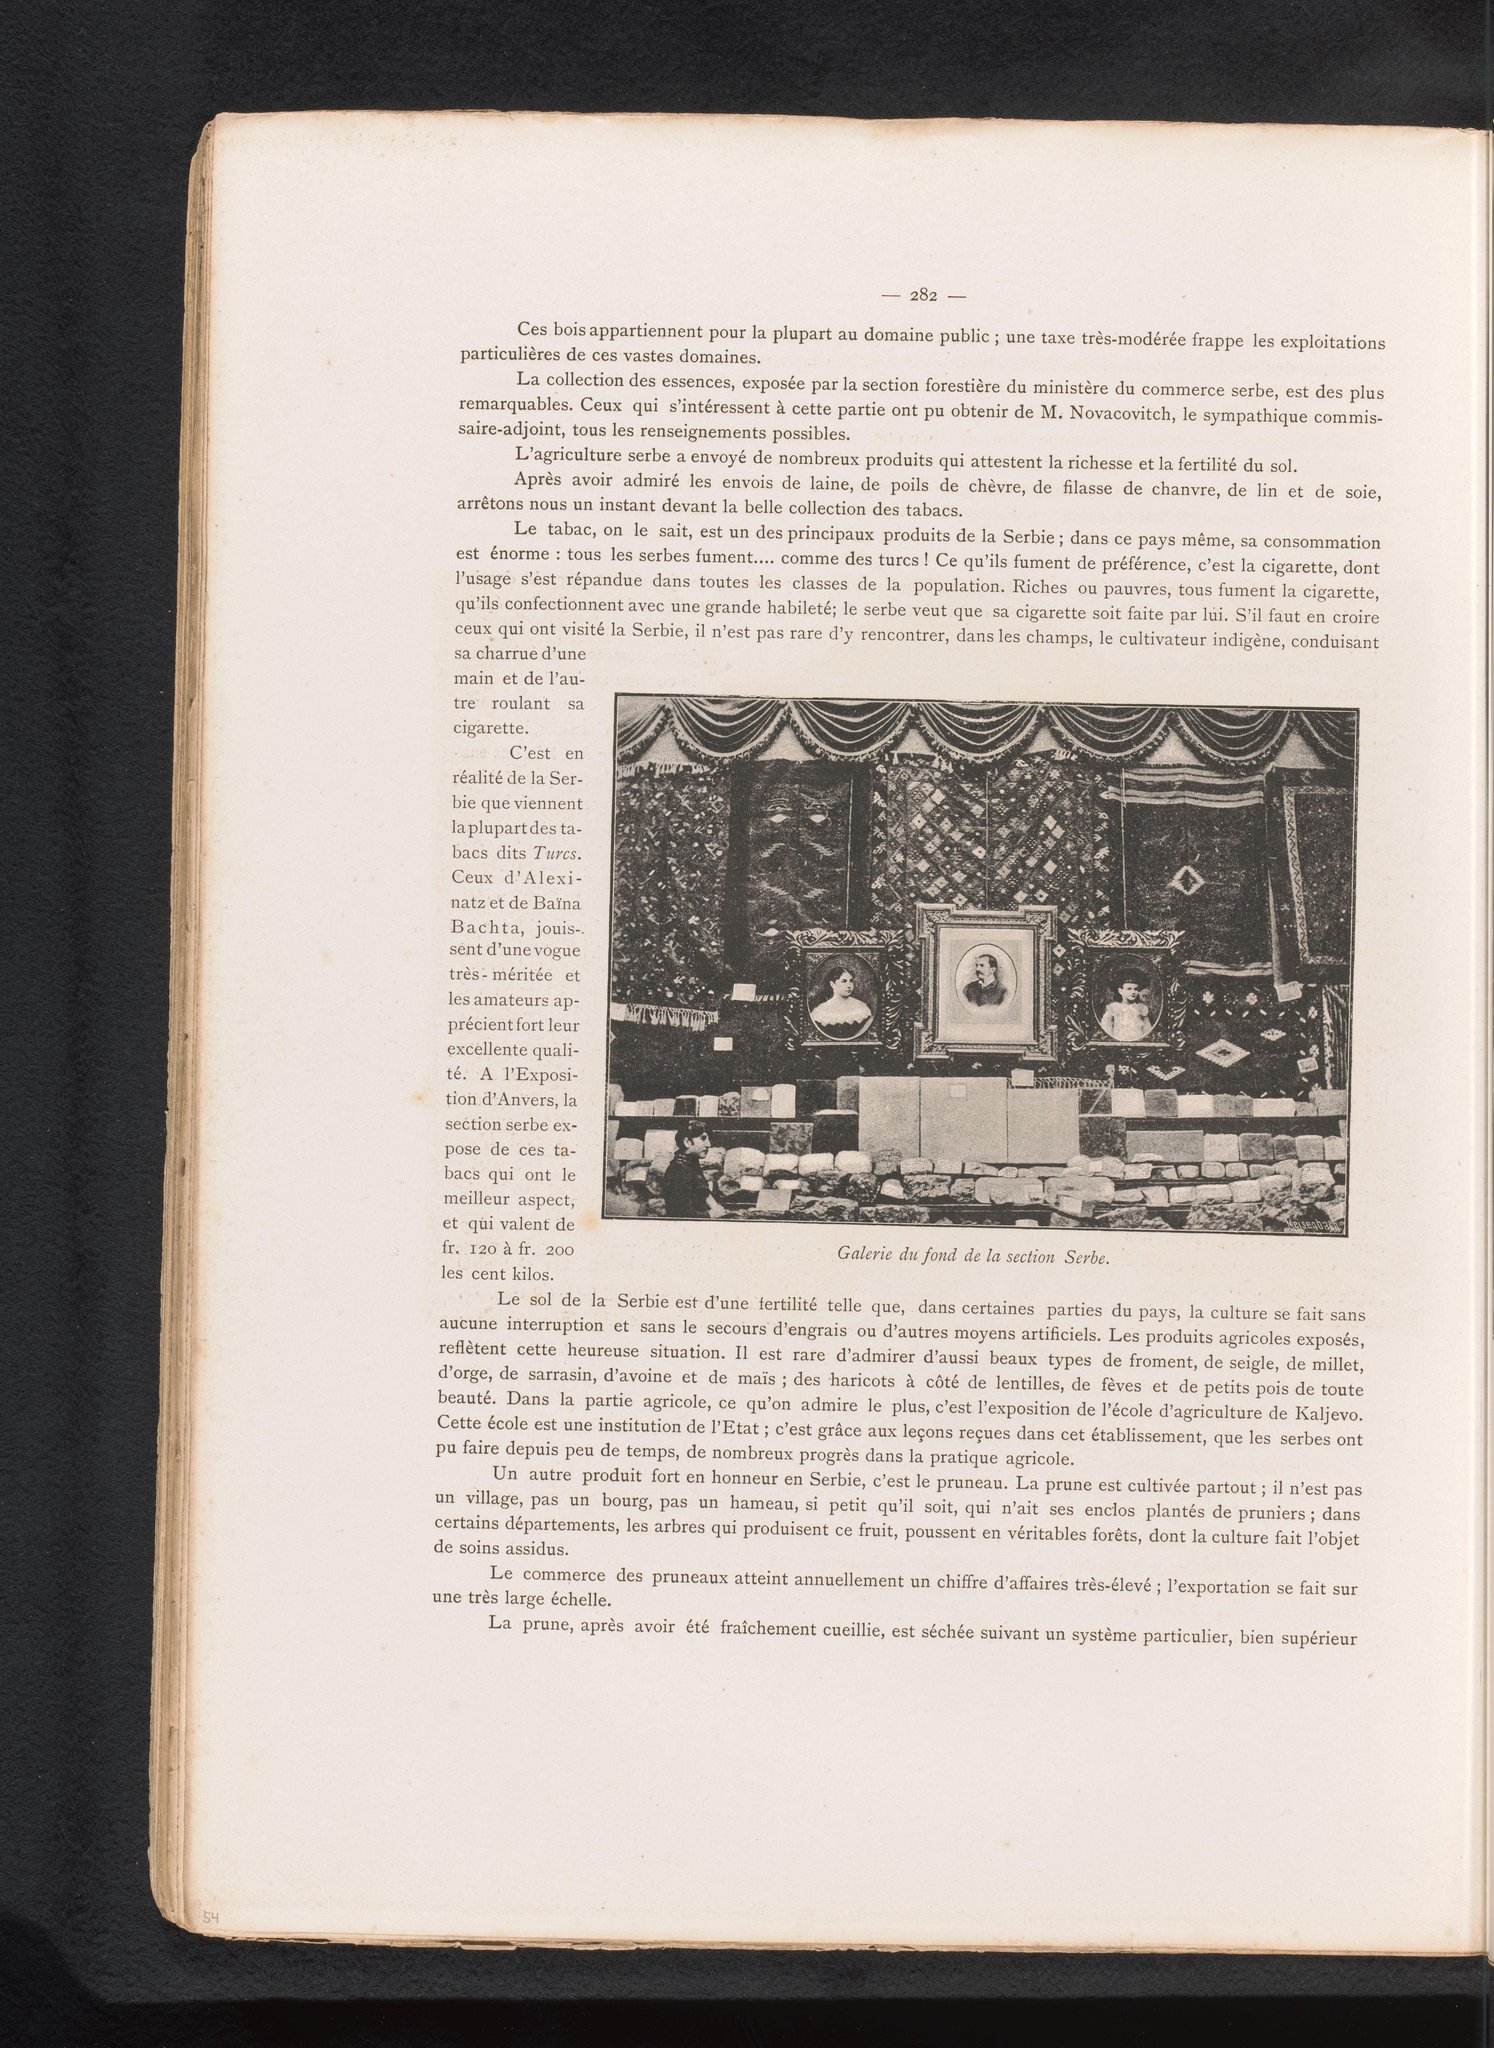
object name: photomechanical print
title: Galerie du fond de la section Serbe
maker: Anonymous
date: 1880-1885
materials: paper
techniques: autotype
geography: antwerp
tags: world fair, world exhibition, antwerp